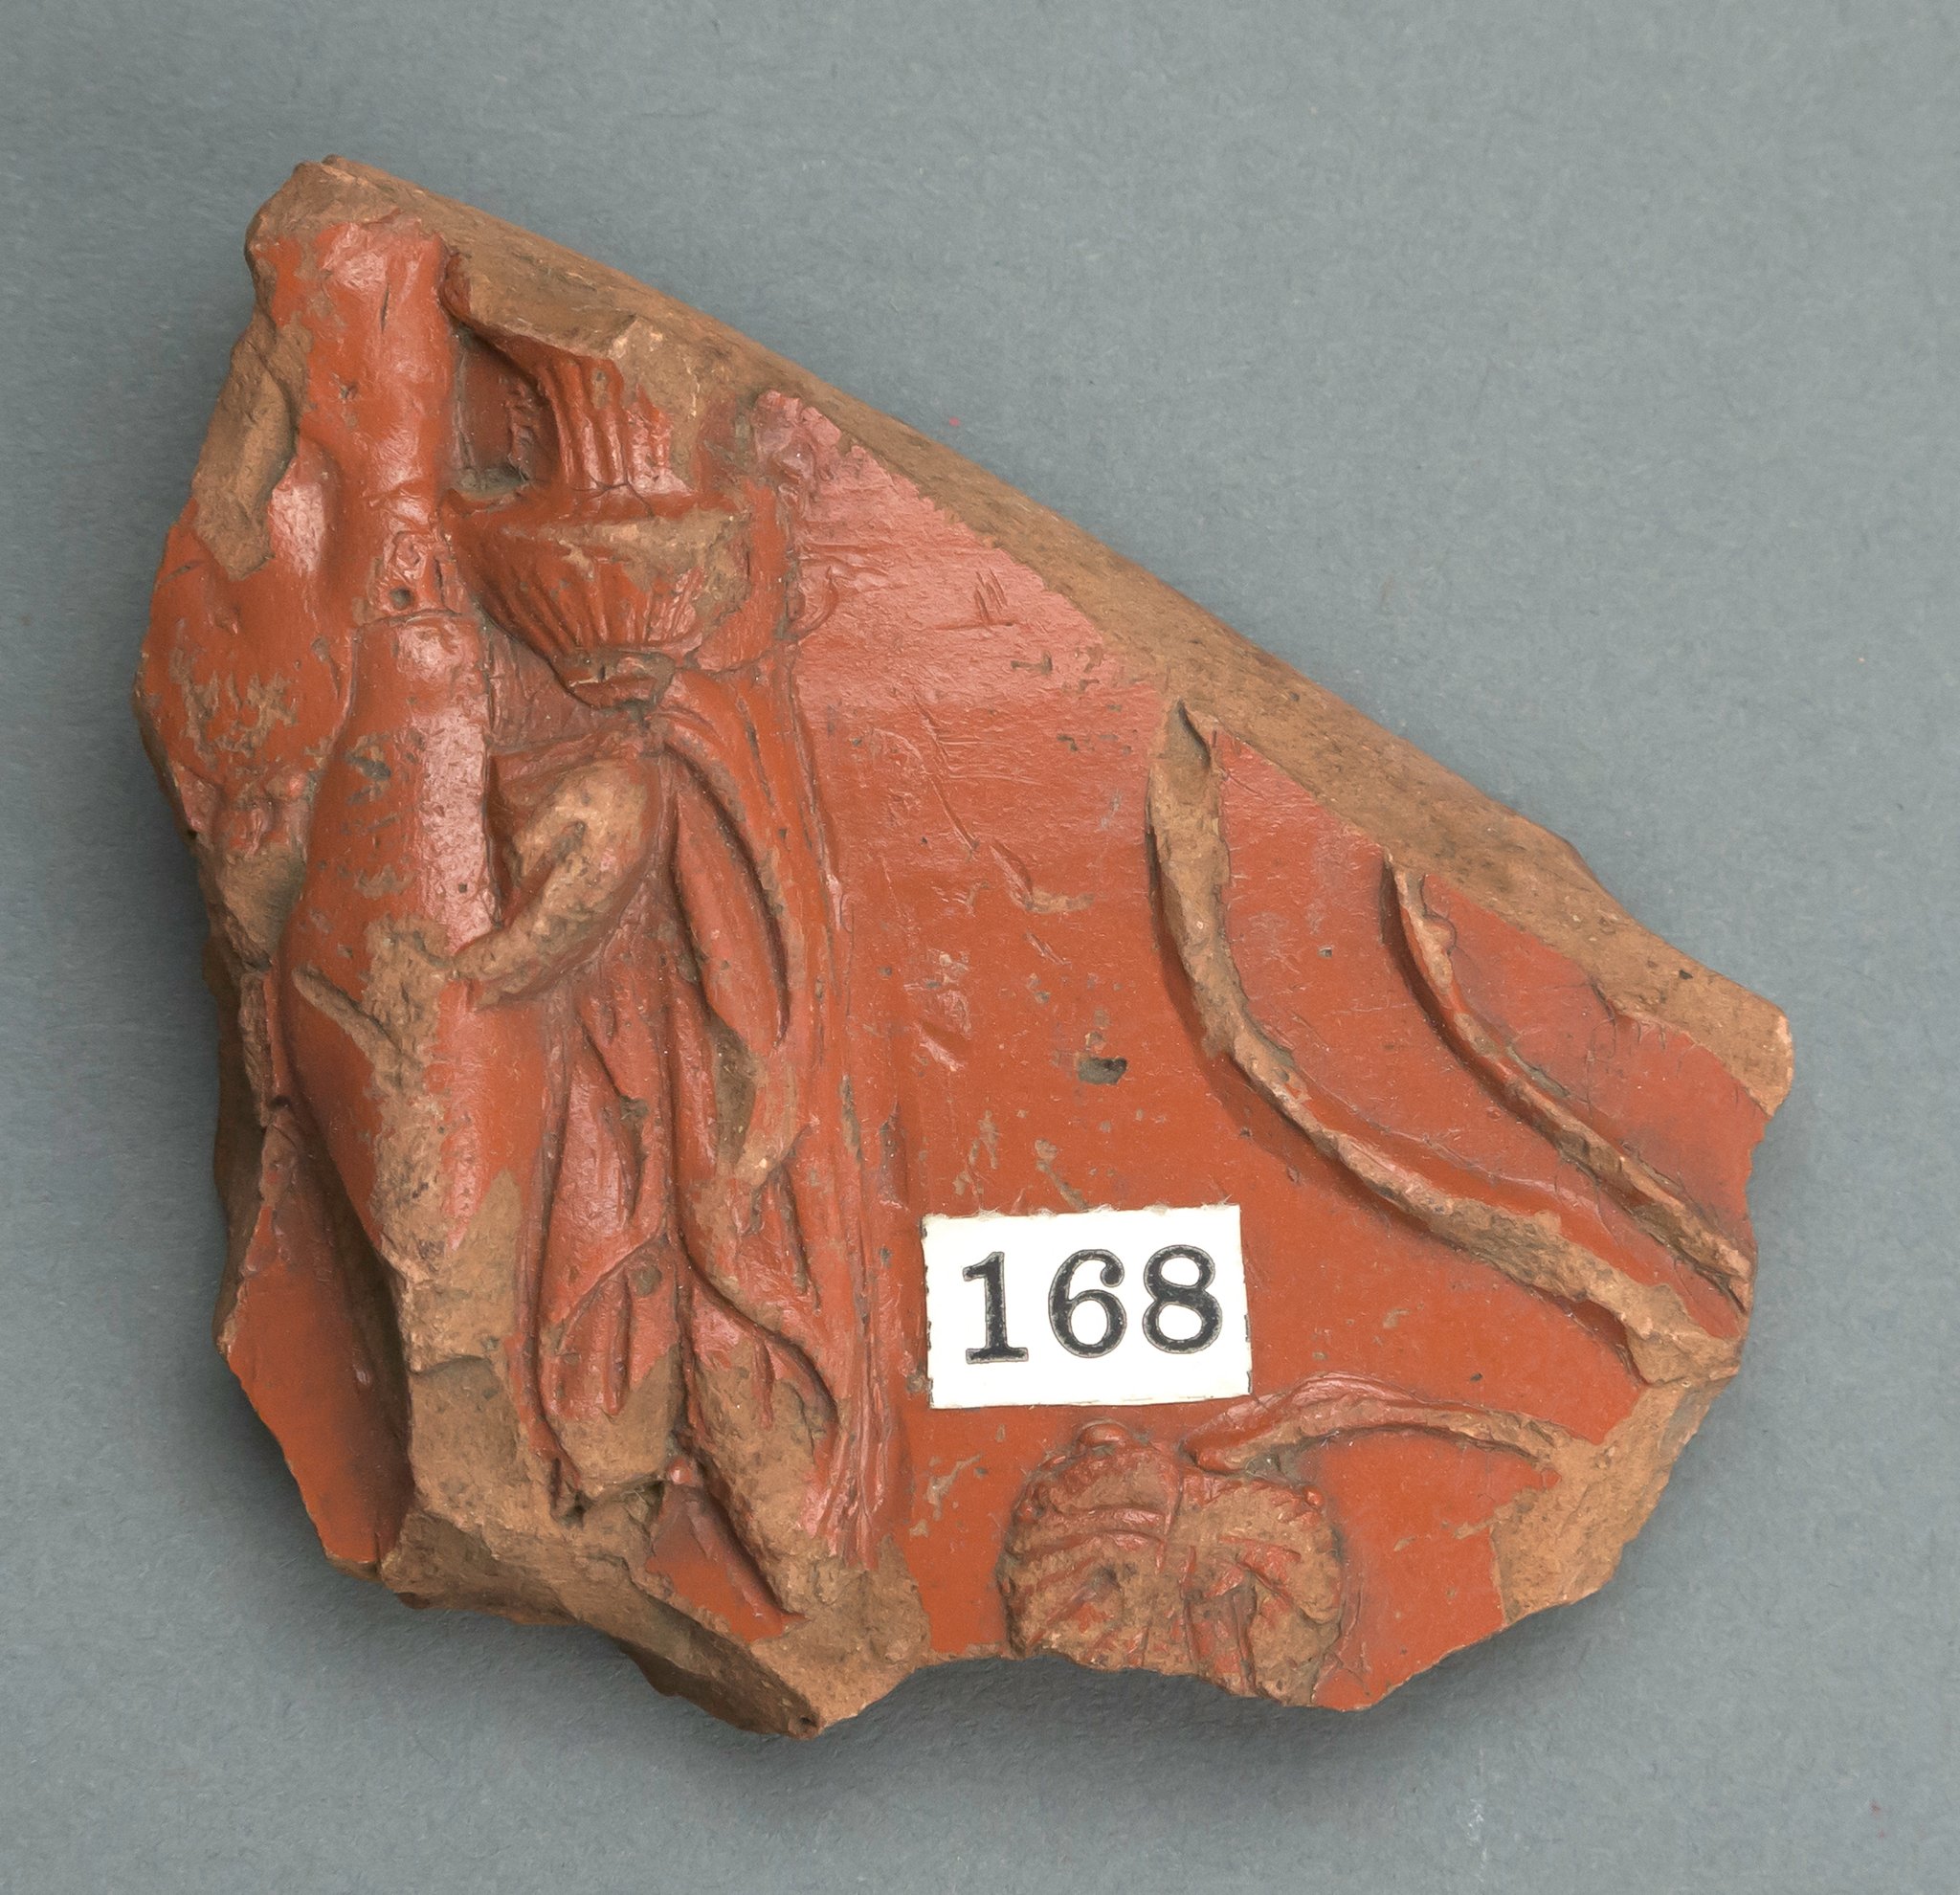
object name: vase fragment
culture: roman, gaul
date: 120 BCE-300 CE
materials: terracotta